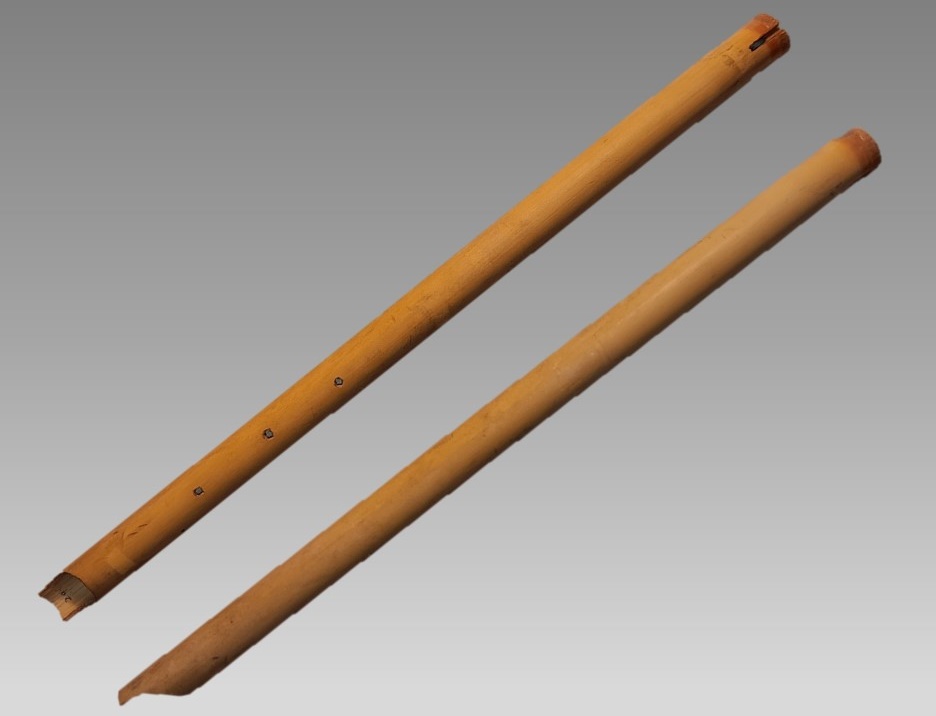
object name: turali or silingut nose flute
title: Turali or Silingut (nose flute)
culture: bornean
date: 1867-1900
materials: bamboo, rattan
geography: borneo